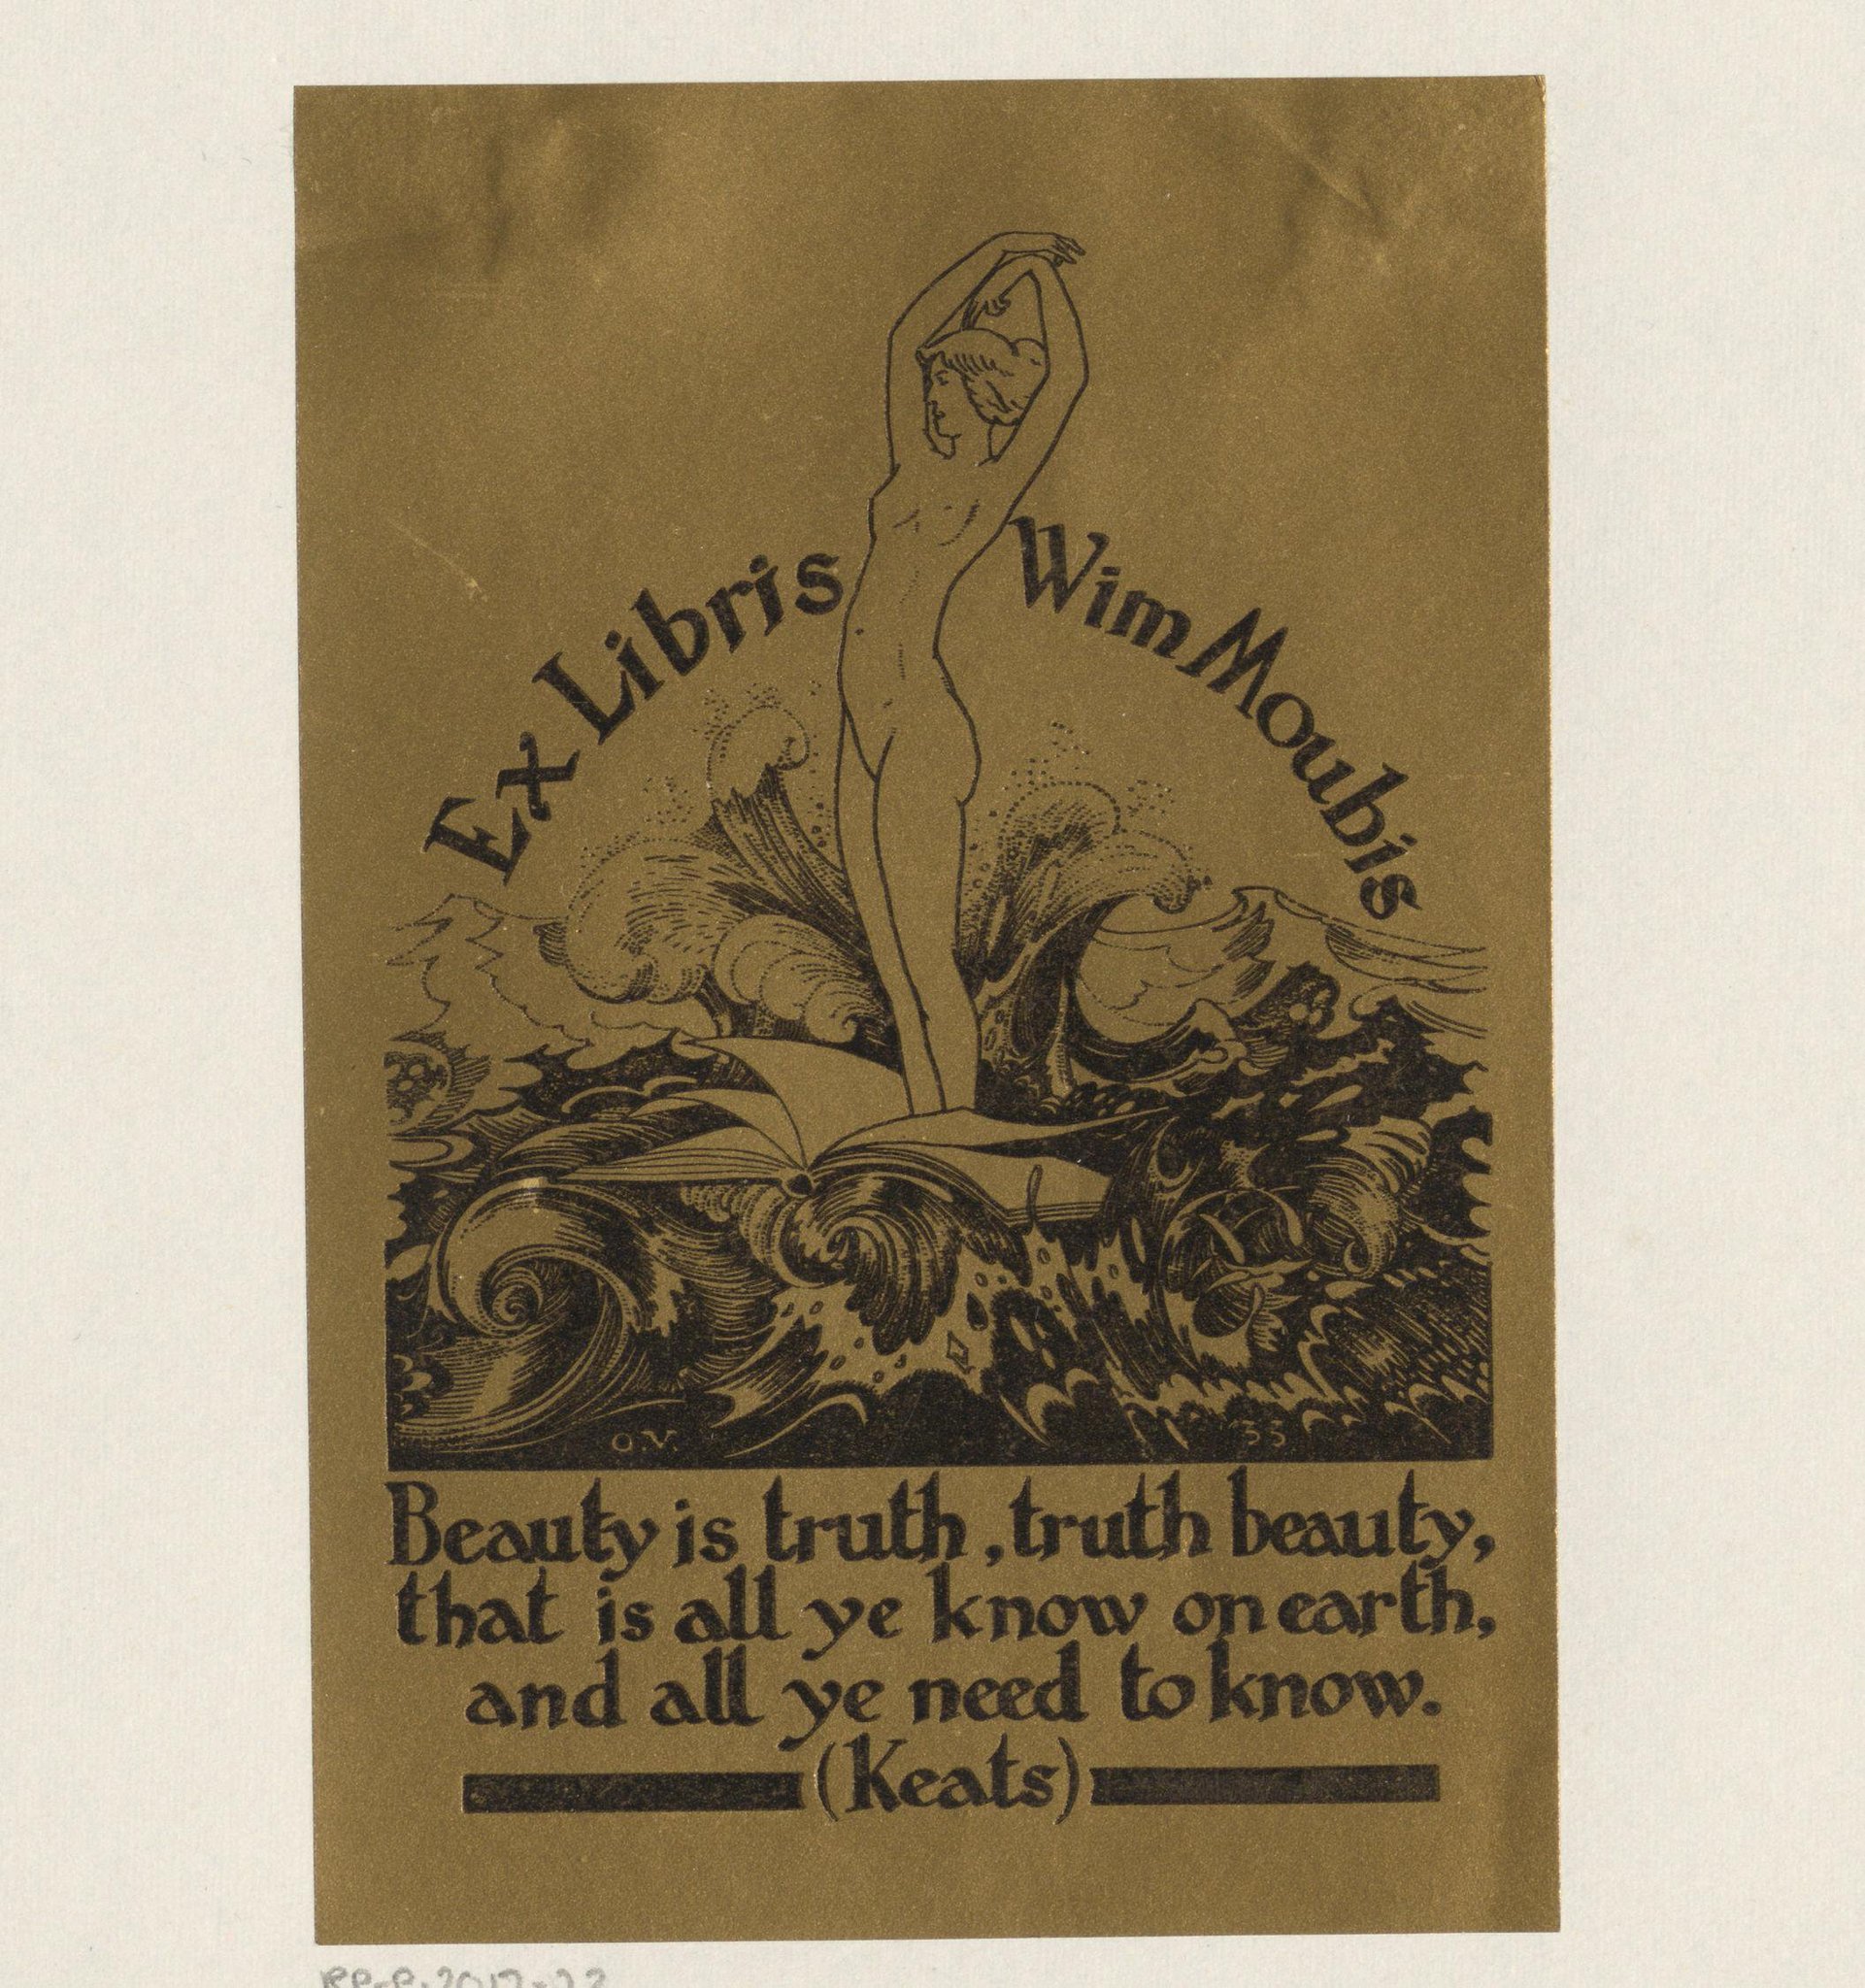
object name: bookplate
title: Ex libris van Wim Moubis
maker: otto verhagen (i)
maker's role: draughtsman, print maker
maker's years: 1885-1951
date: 1933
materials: paper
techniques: printing block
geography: noordwijk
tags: wave, birth of venus; venus anadyomene: after uranus' castration venus rises from the sea wringing the water from her hair; usually she is awaited by the hours, book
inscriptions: date